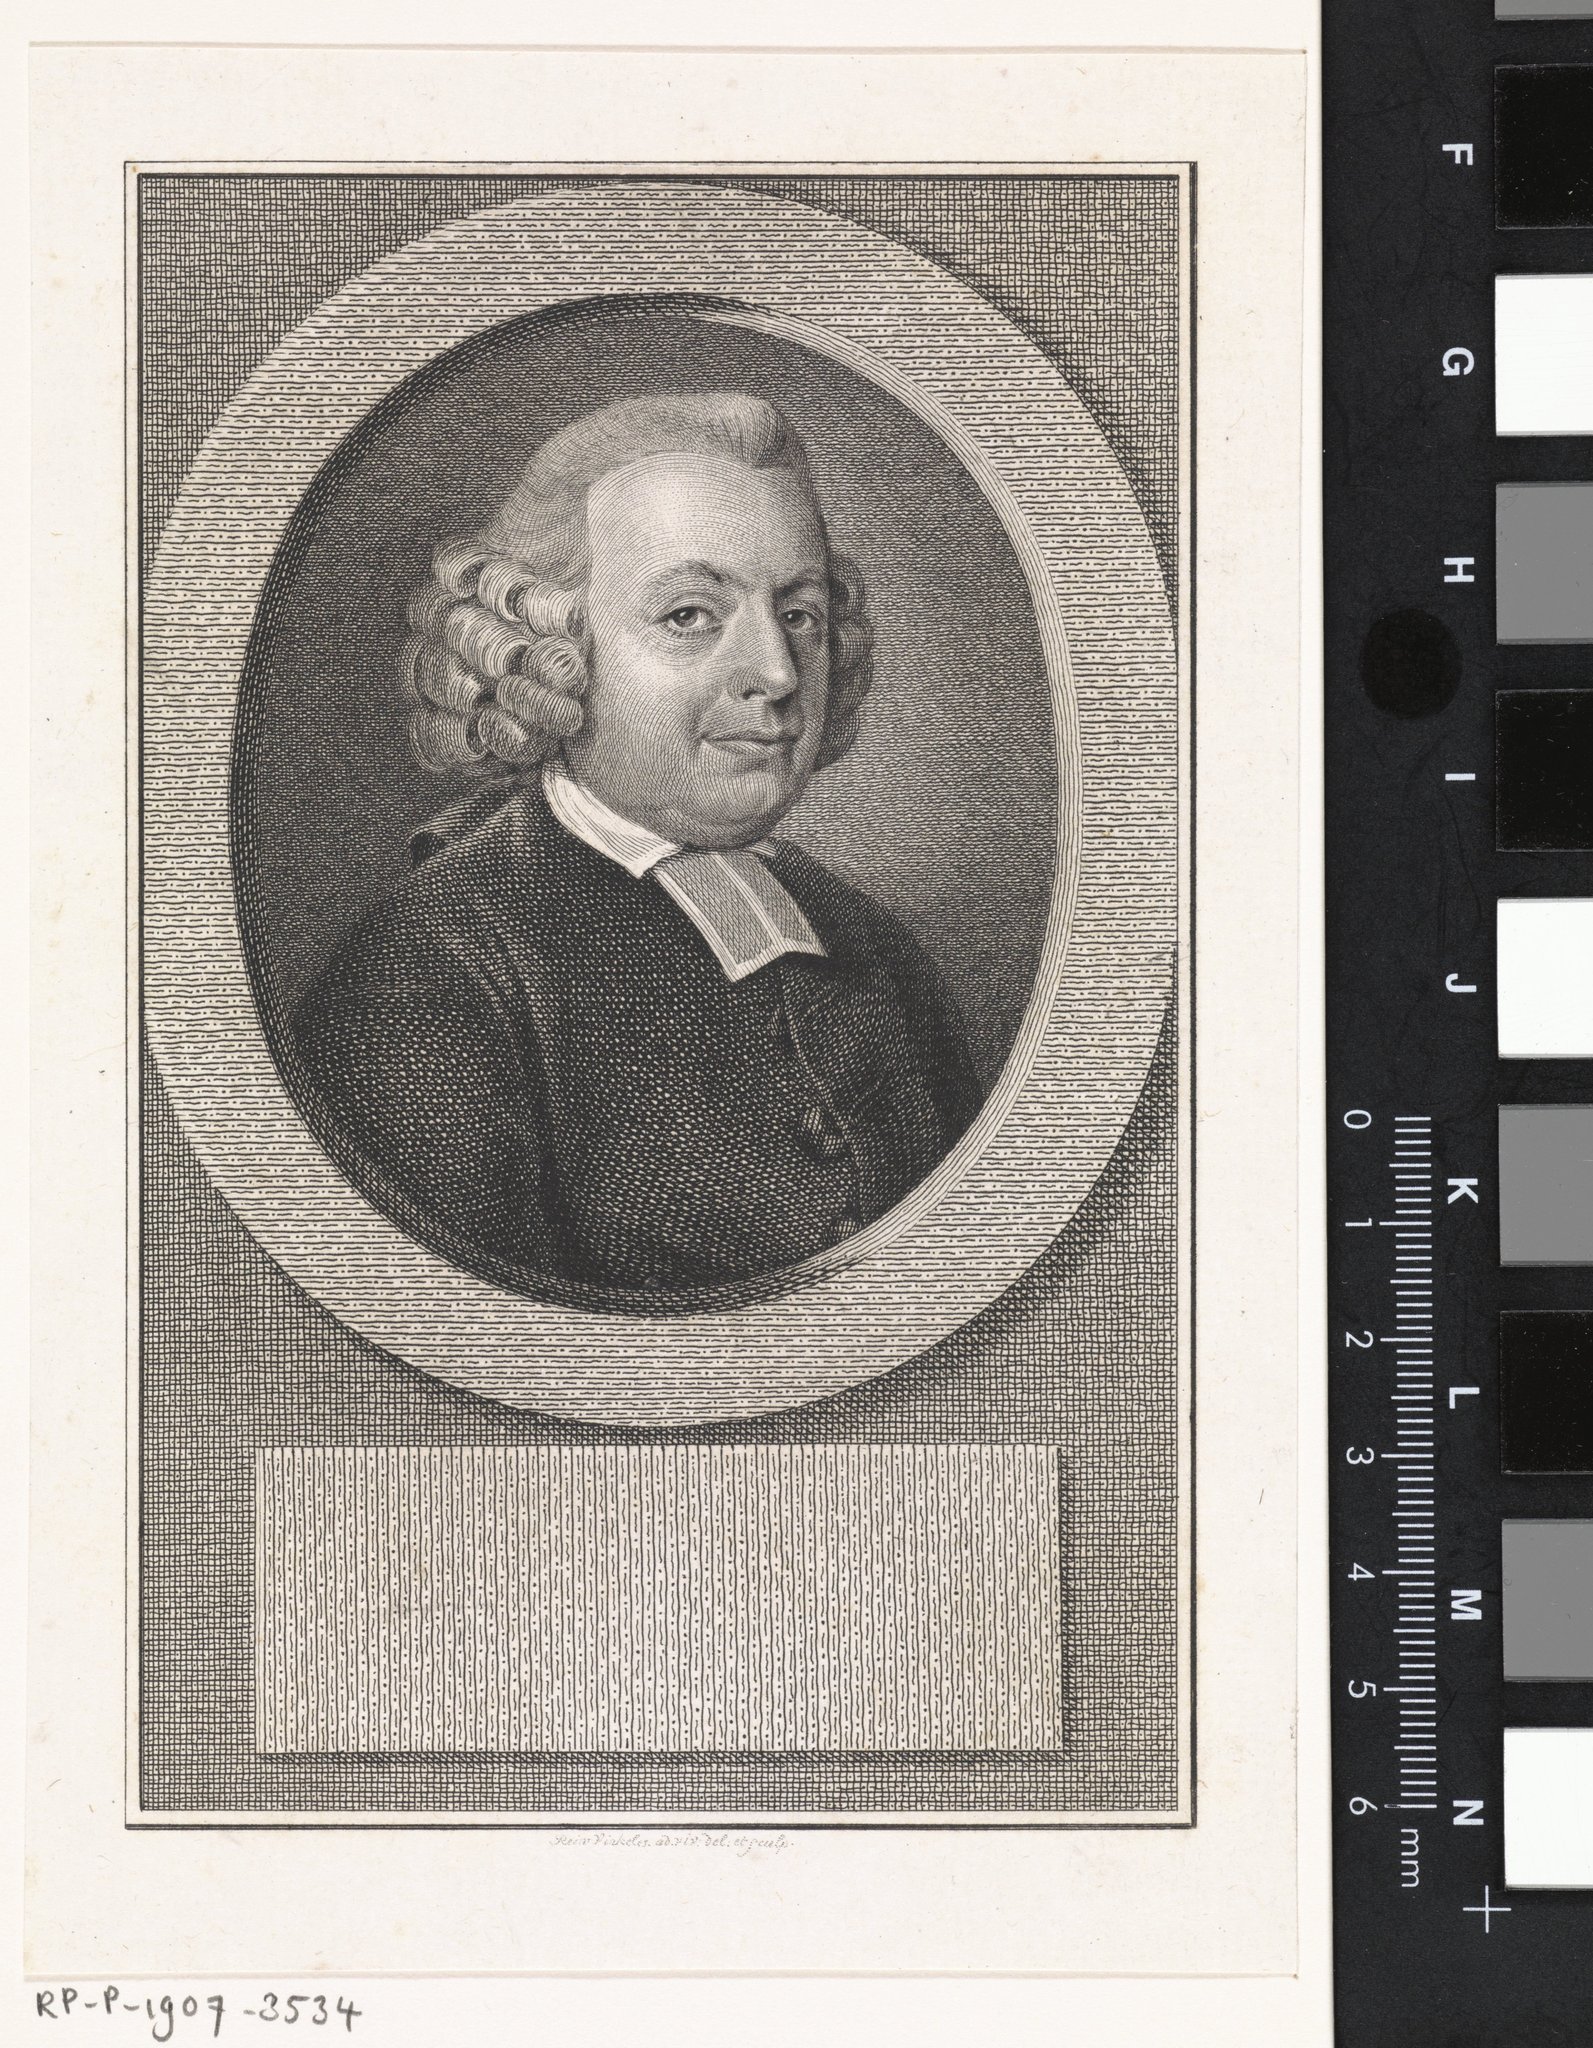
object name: print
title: Portret van Augustus Sterk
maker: reinier vinkeles (i)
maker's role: draughtsman, print maker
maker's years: 1741-1816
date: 1794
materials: paper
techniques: engraving, etching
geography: amsterdam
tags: haarlem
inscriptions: collector's mark: Lugt 2228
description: Portret van Augustus Sterk, Luthers predikant te Amsterdam.